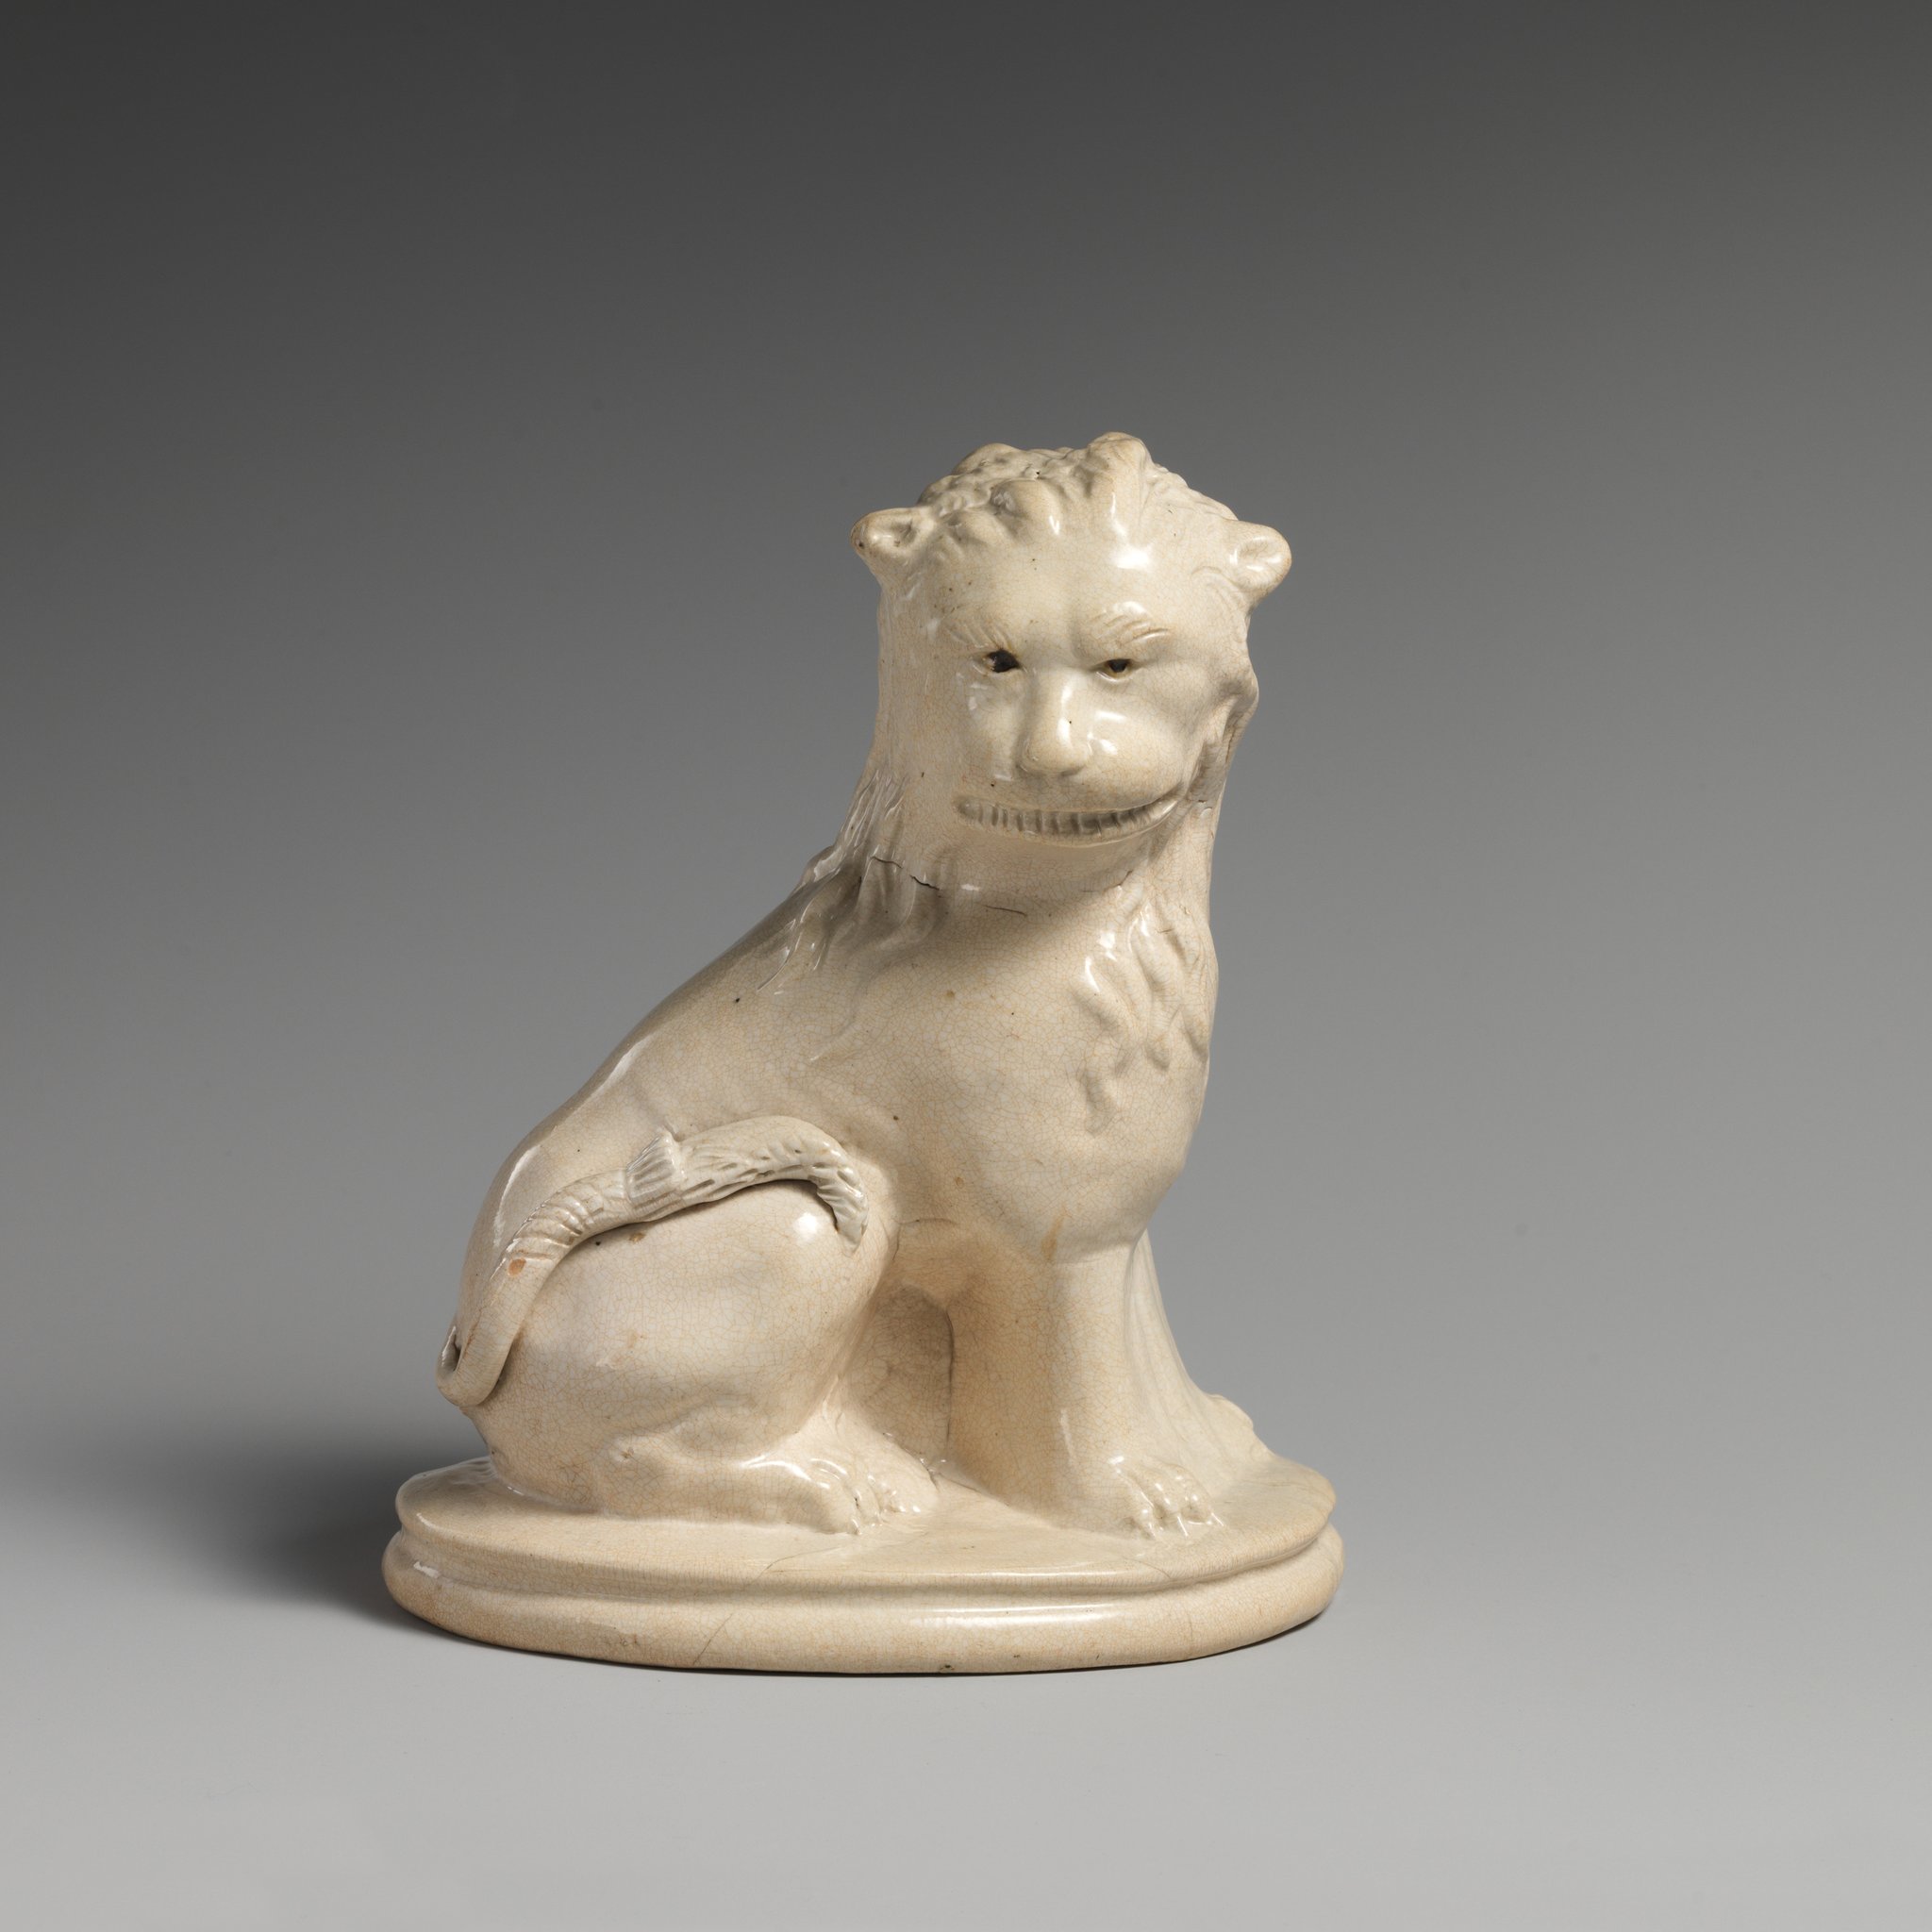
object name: figure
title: Lion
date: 1740-1750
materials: stoneware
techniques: salt glaze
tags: lions